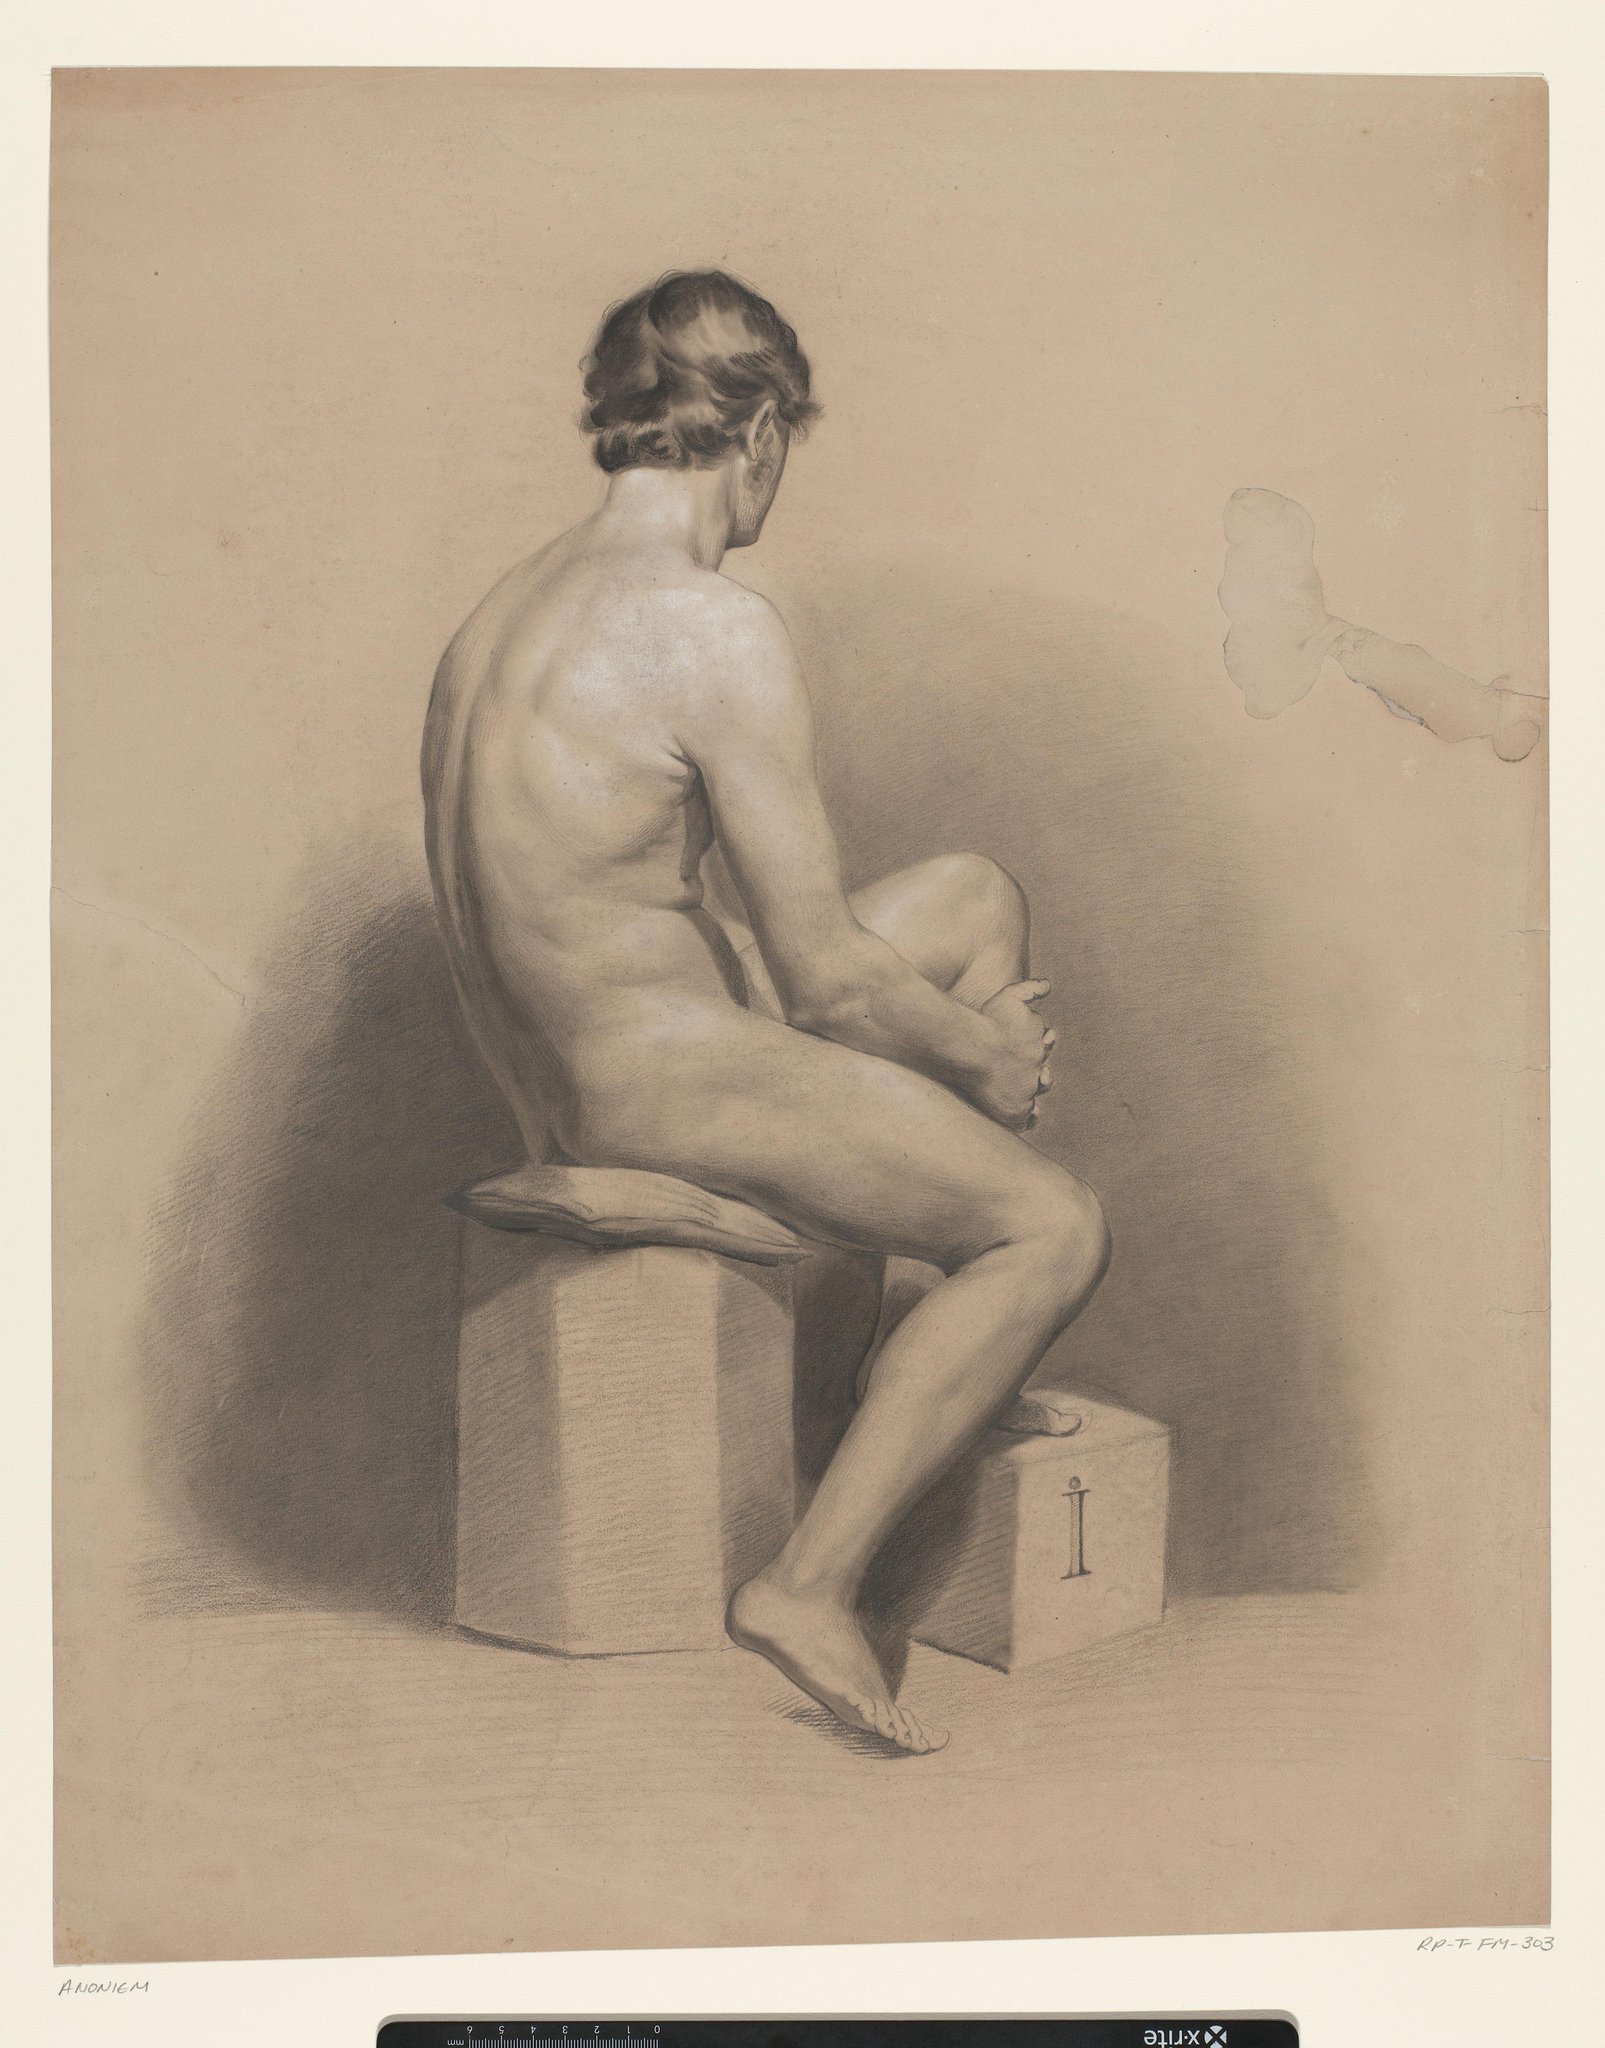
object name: drawing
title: Zittend mannelijk naakt, op een blok, naar rechts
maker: Anonymous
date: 1800-1900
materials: chalk, paper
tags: sitting figure